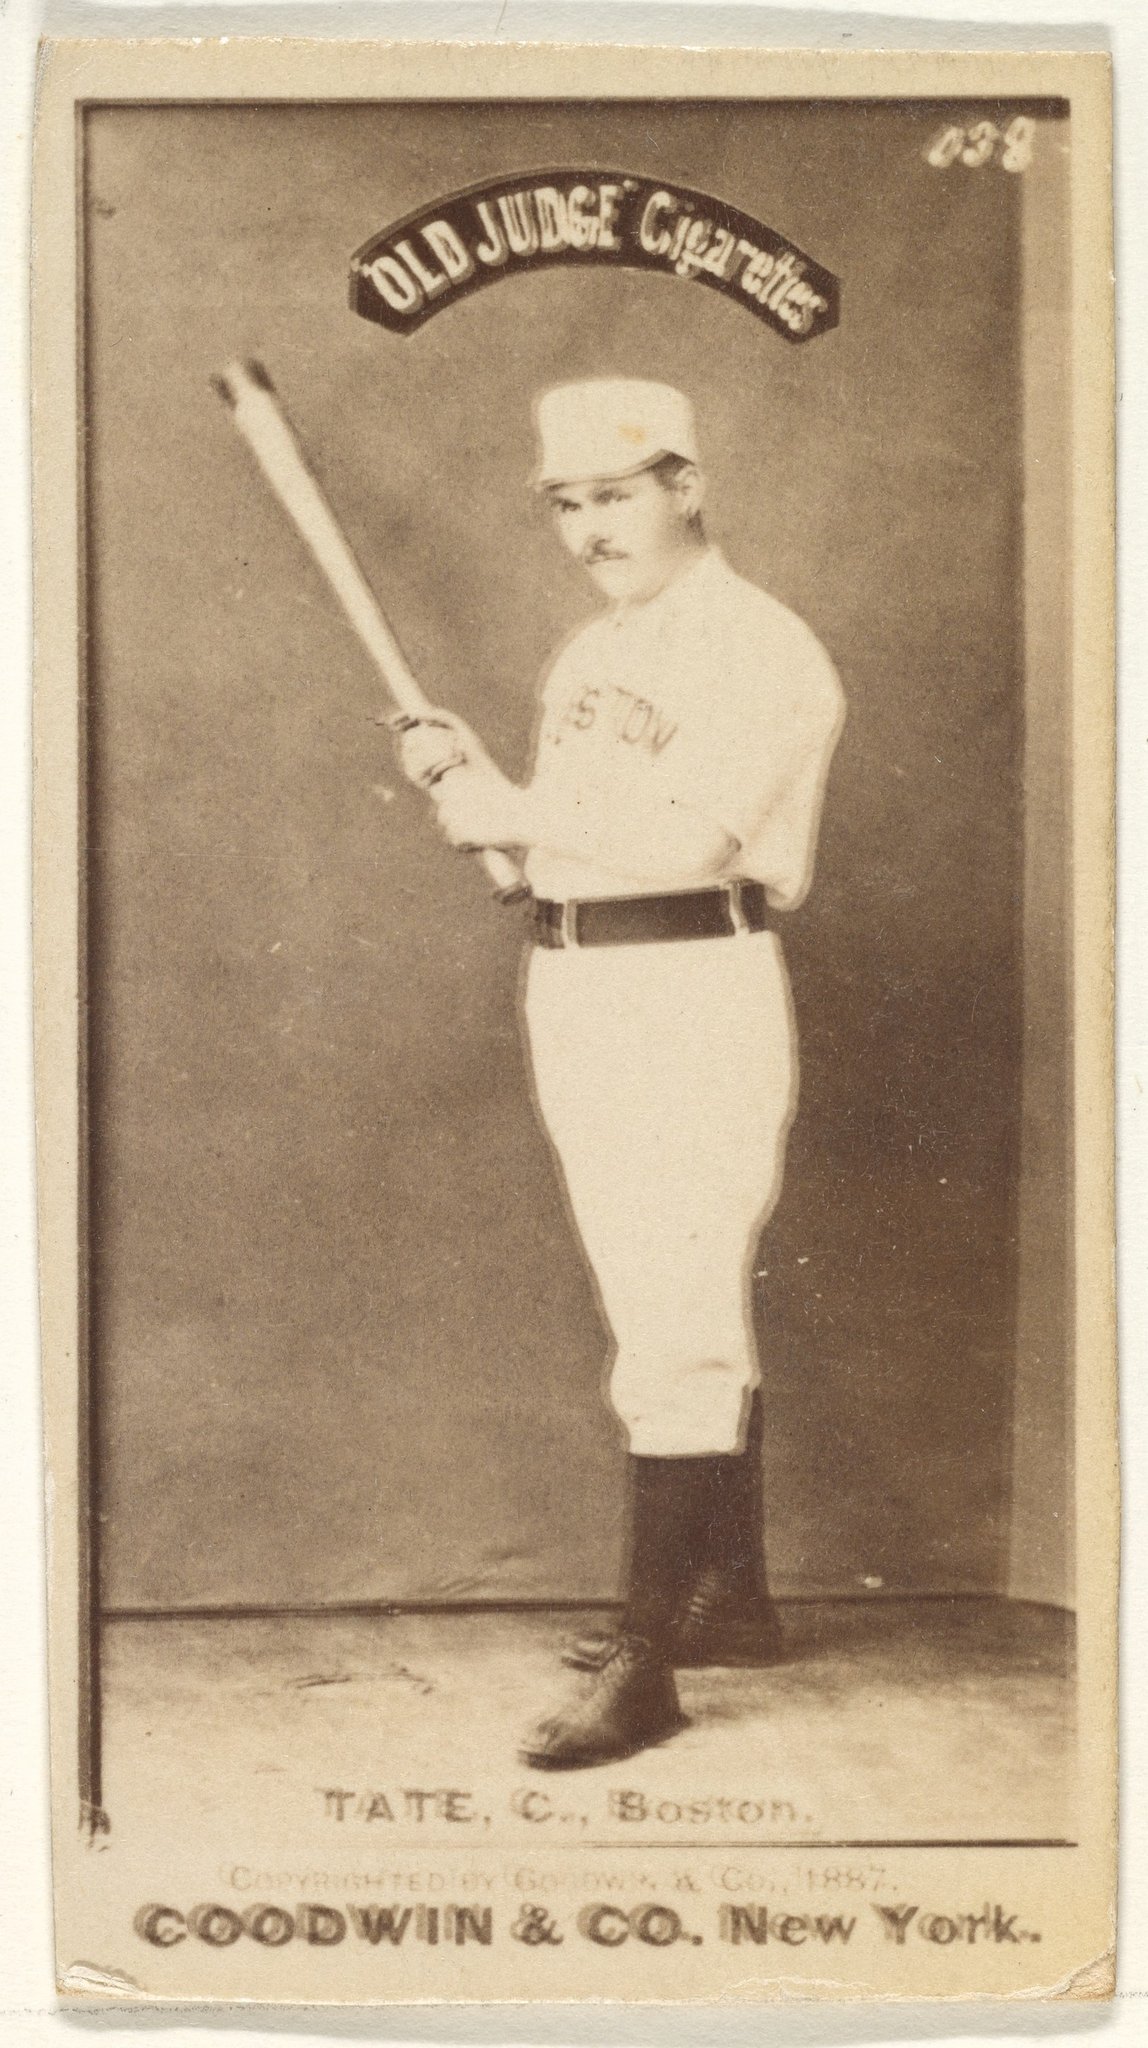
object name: baseball card, photograph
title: Tate, Catcher, Boston, from the Old Judge series (N172) for Old Judge Cigarettes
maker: goodwin & company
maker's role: publisher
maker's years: 1850-1950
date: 1887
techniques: albumen silver print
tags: men,portraits,baseball,athletes